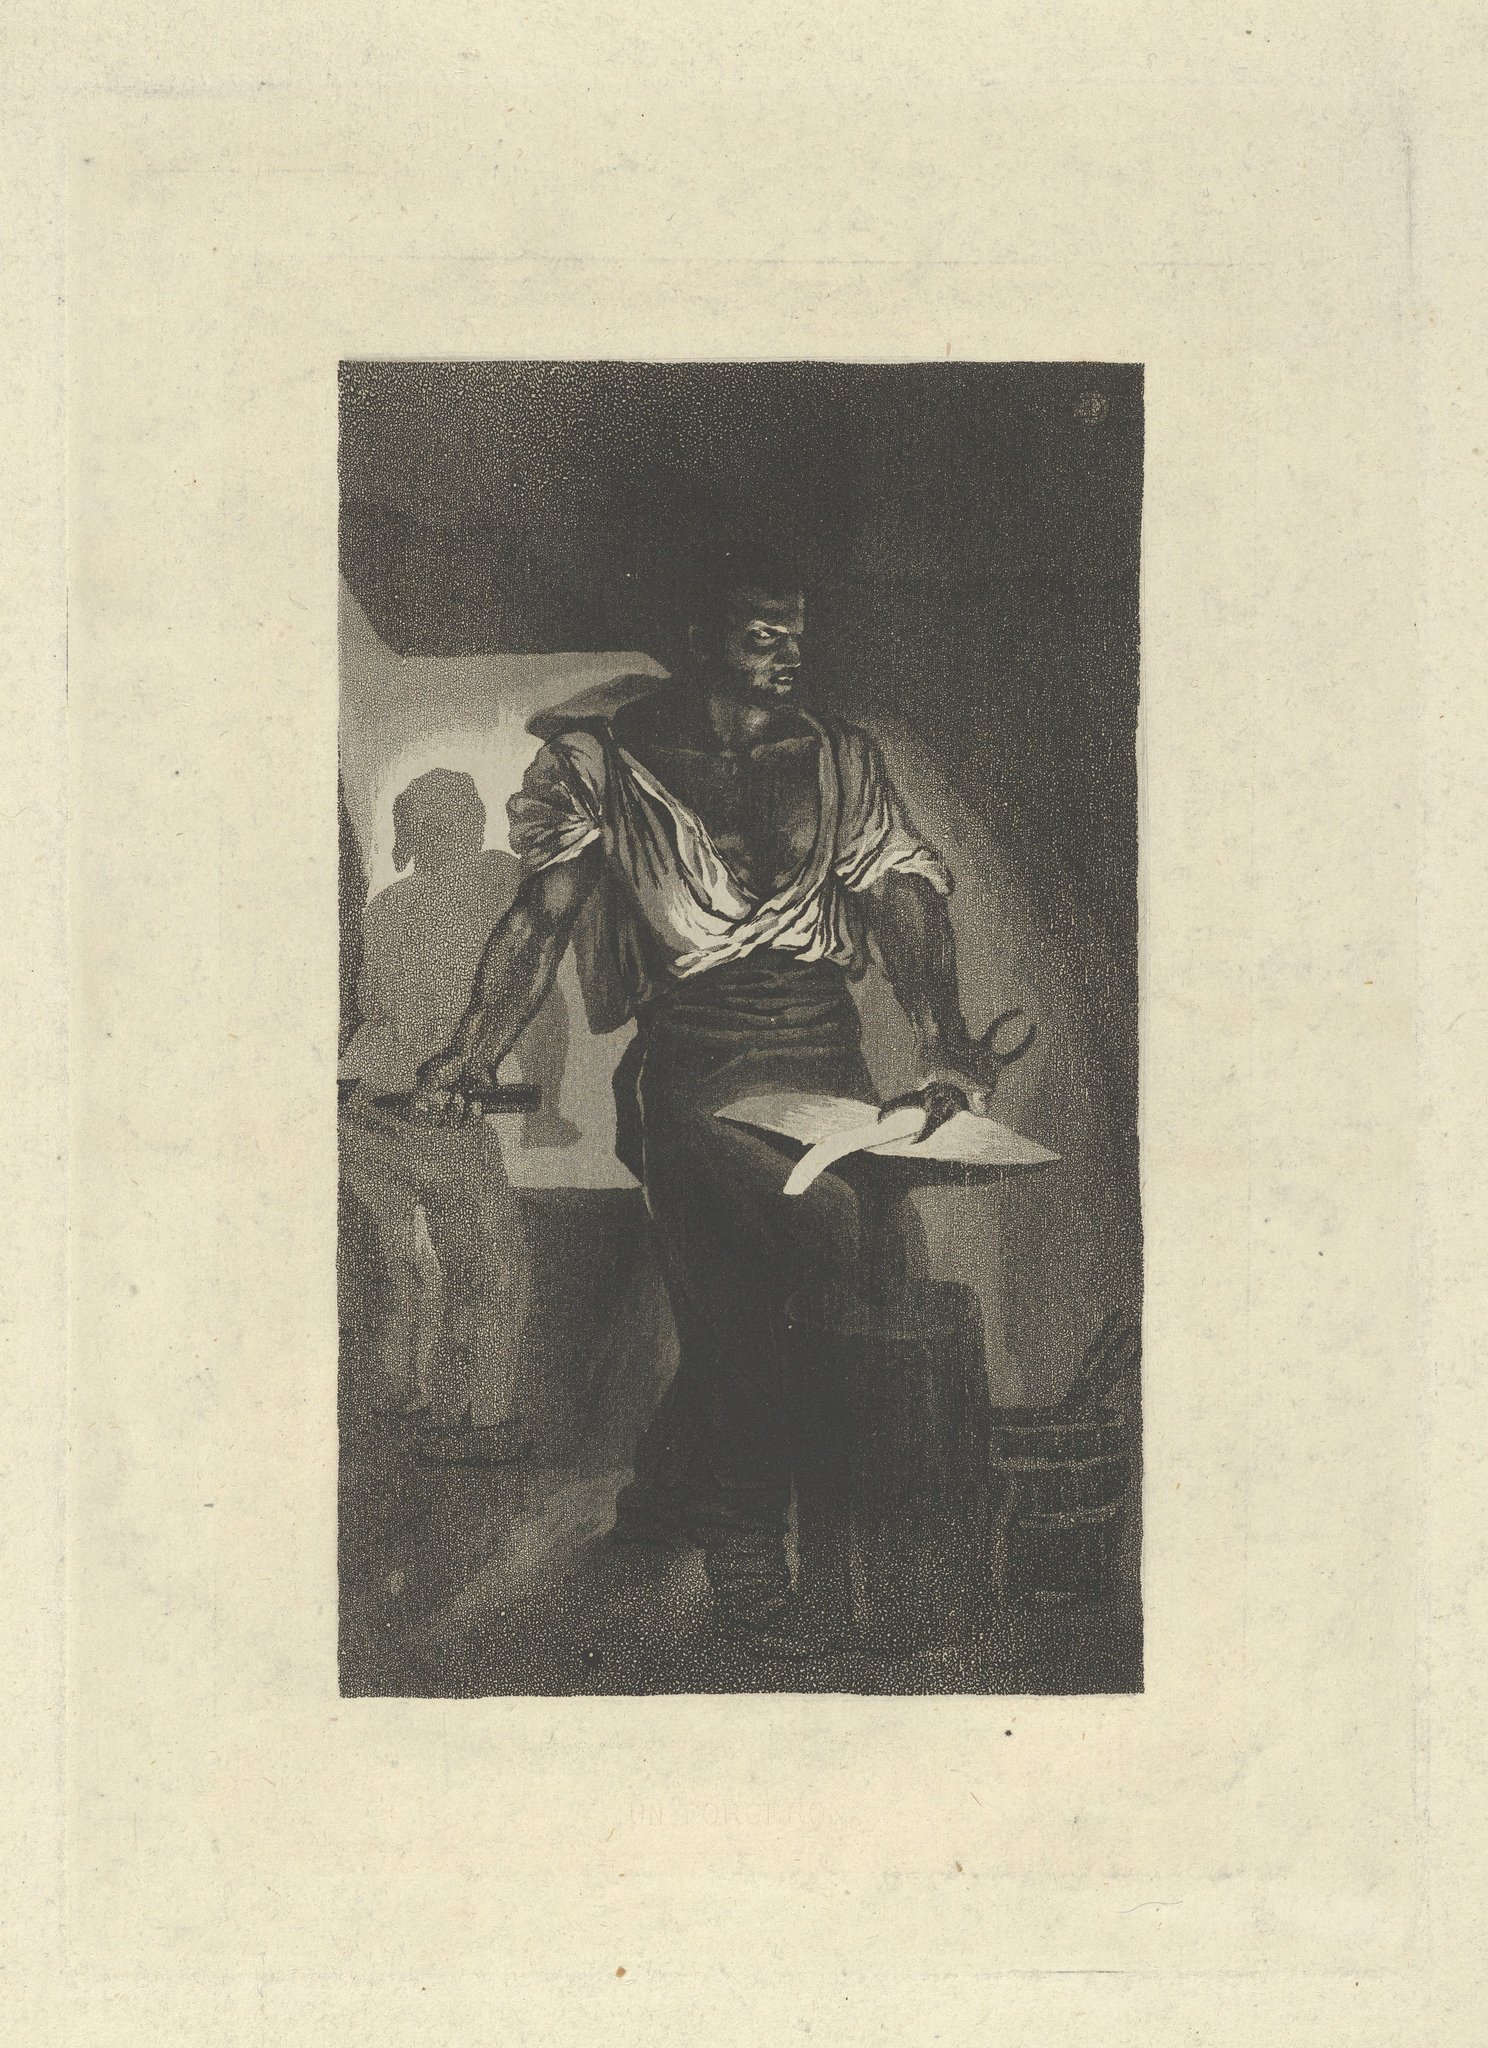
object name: print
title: A Blacksmith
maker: eugène delacroix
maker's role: artist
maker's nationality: french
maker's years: 1798-1863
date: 1833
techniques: aquatint, drypoint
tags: men,blacksmiths